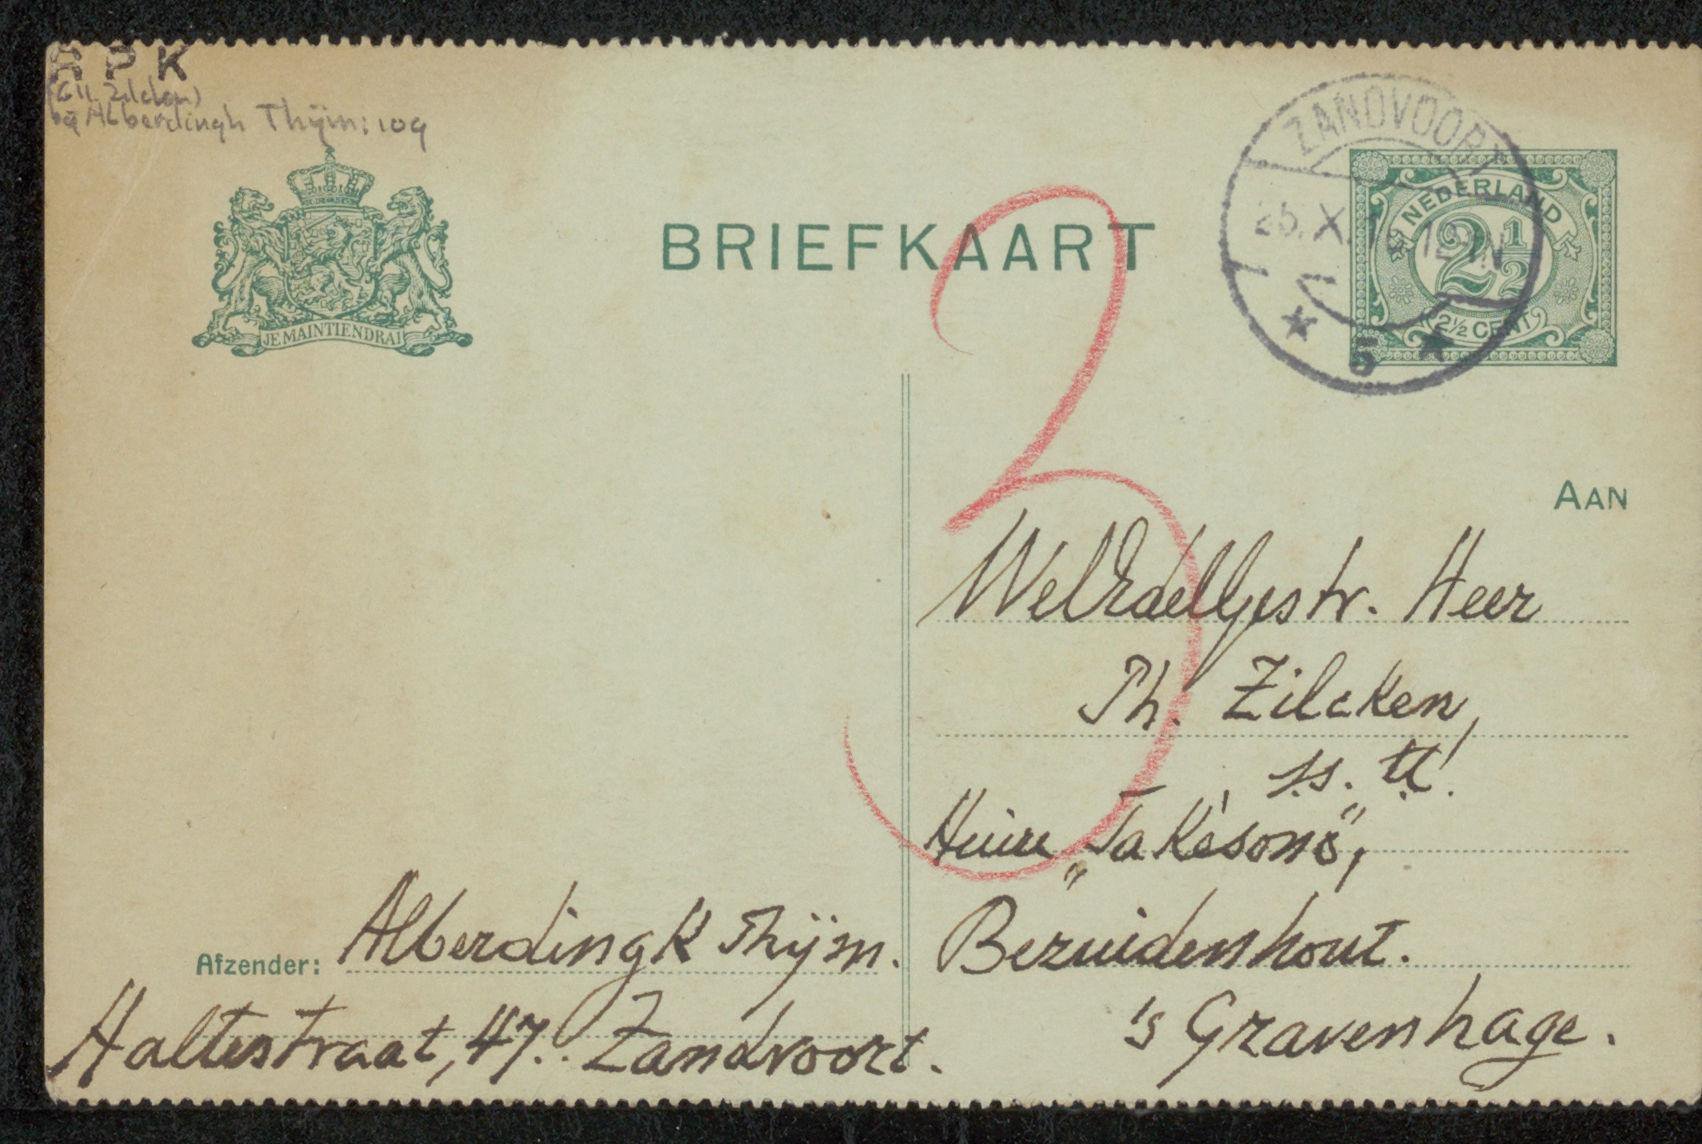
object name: postcard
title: Briefkaart aan Philip Zilcken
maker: karel johan lodewijk alberdingk thijm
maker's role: criticus, prozaschrijver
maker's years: 1864-1952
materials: cardboard, ink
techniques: pen, writing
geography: zandvoort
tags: the hague, painter, draughtsman, philip zilcken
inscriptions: collector's mark: ‘RPK’